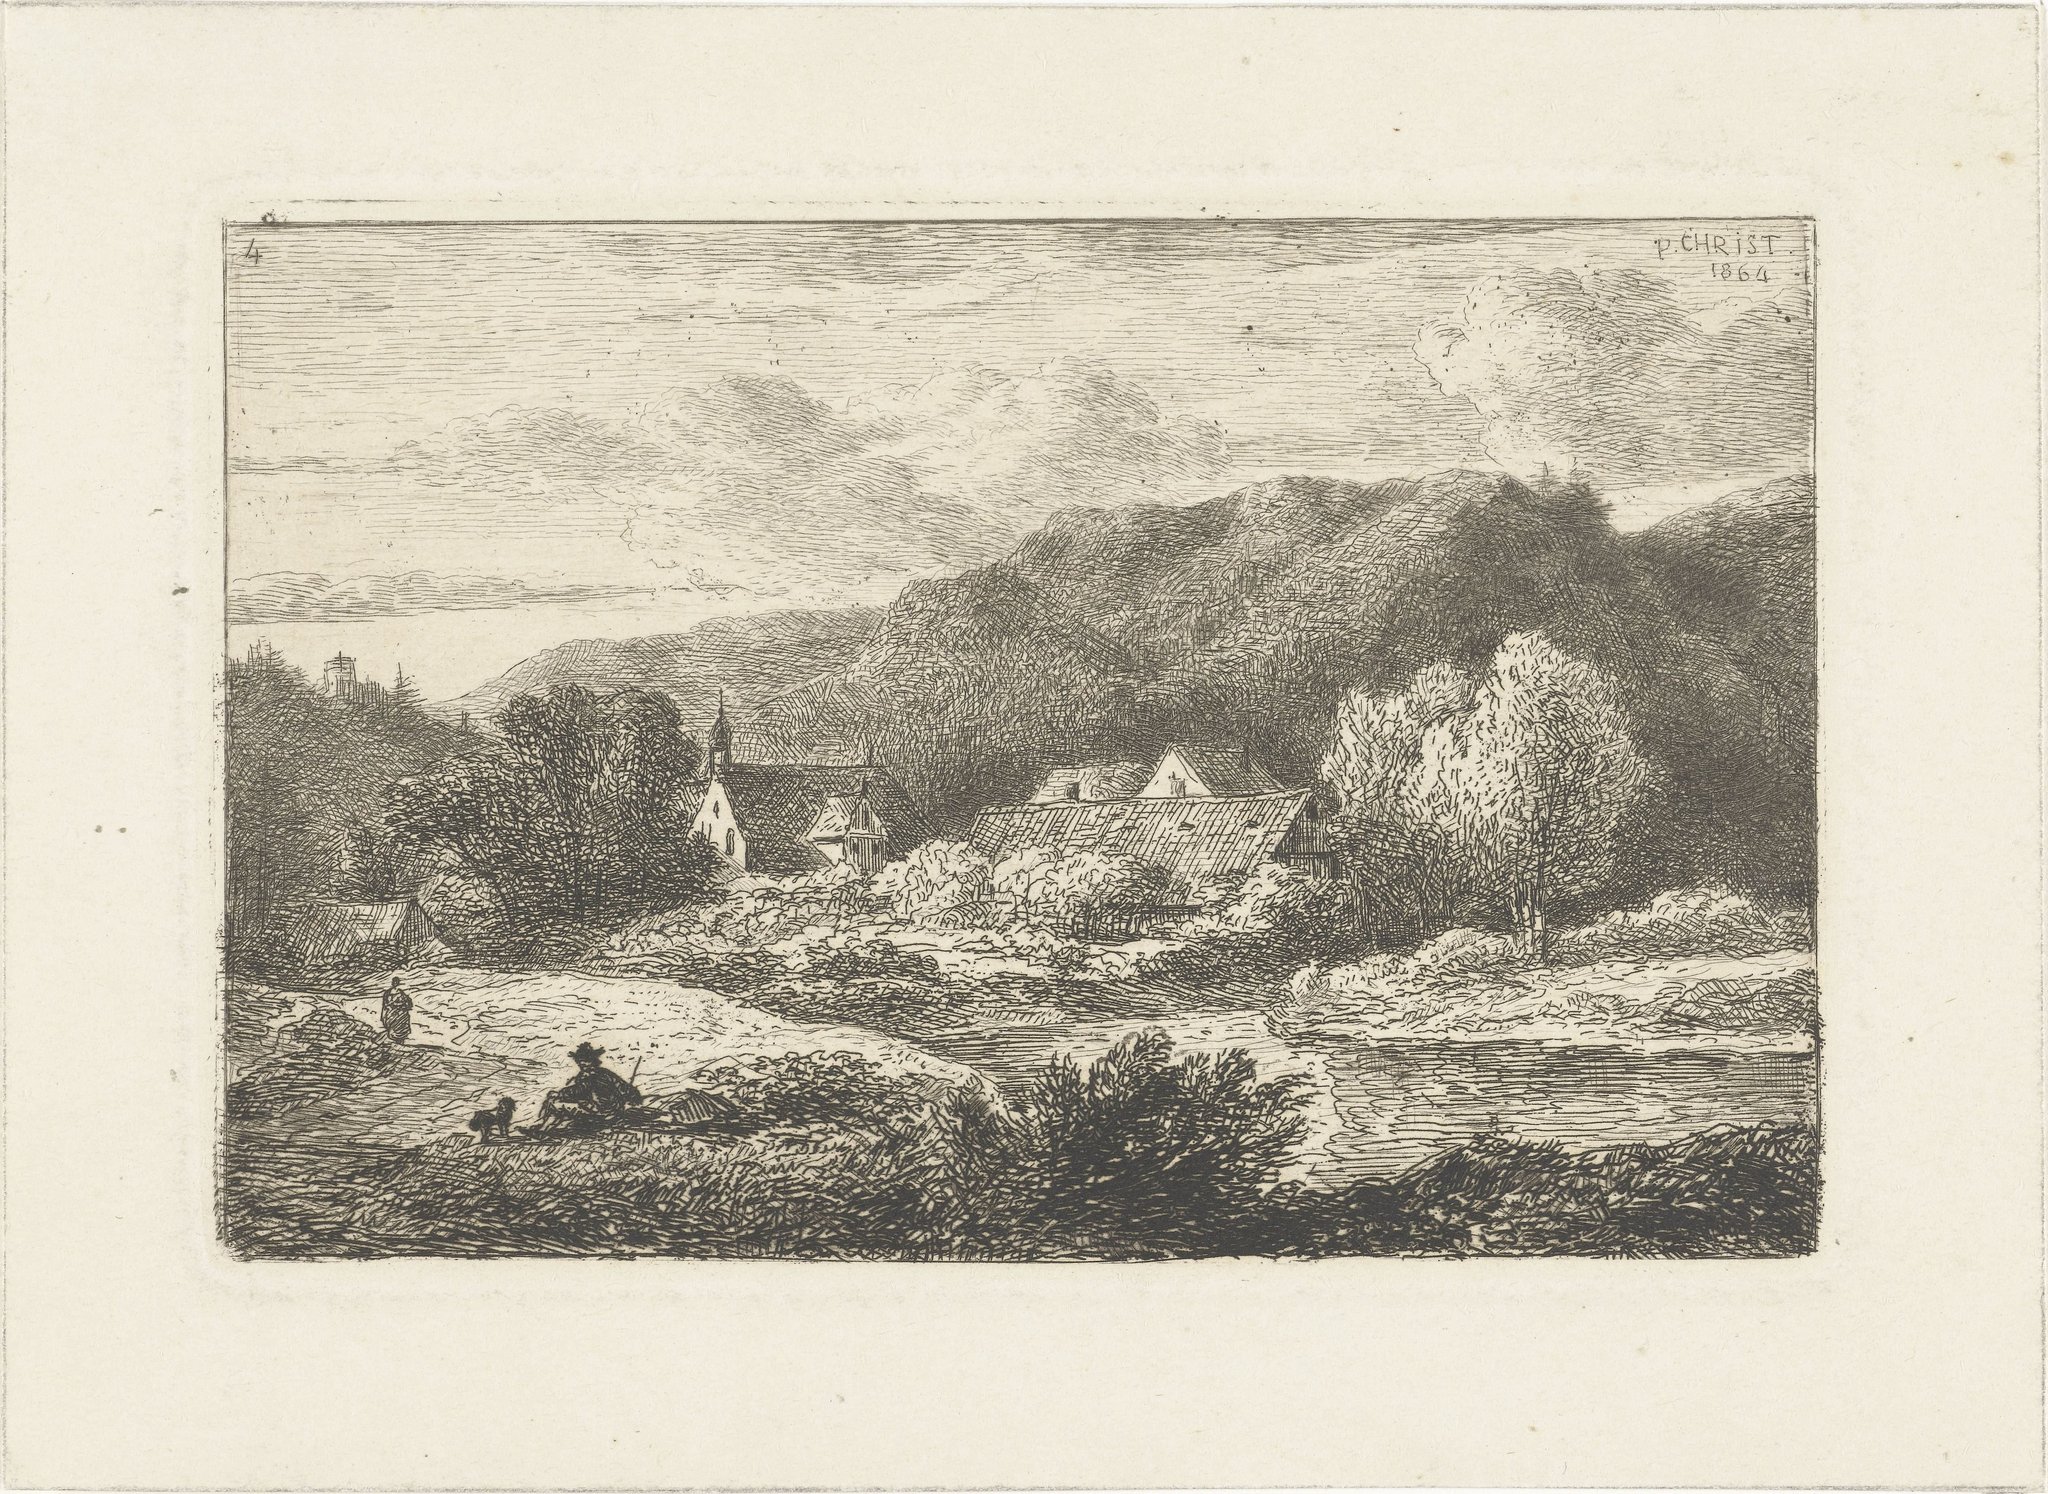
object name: print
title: Heuvellandschap met kerkje en huizen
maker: pieter casper christ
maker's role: draughtsman, print maker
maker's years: 1822-1888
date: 1864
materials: paper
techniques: etching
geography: arnhem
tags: landscapes in the temperate zone, landscapes with waters, waterscapes, seascapes (in the temperate zone) (+ landscape with figures, staffage)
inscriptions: collector's mark: Lugt 2228